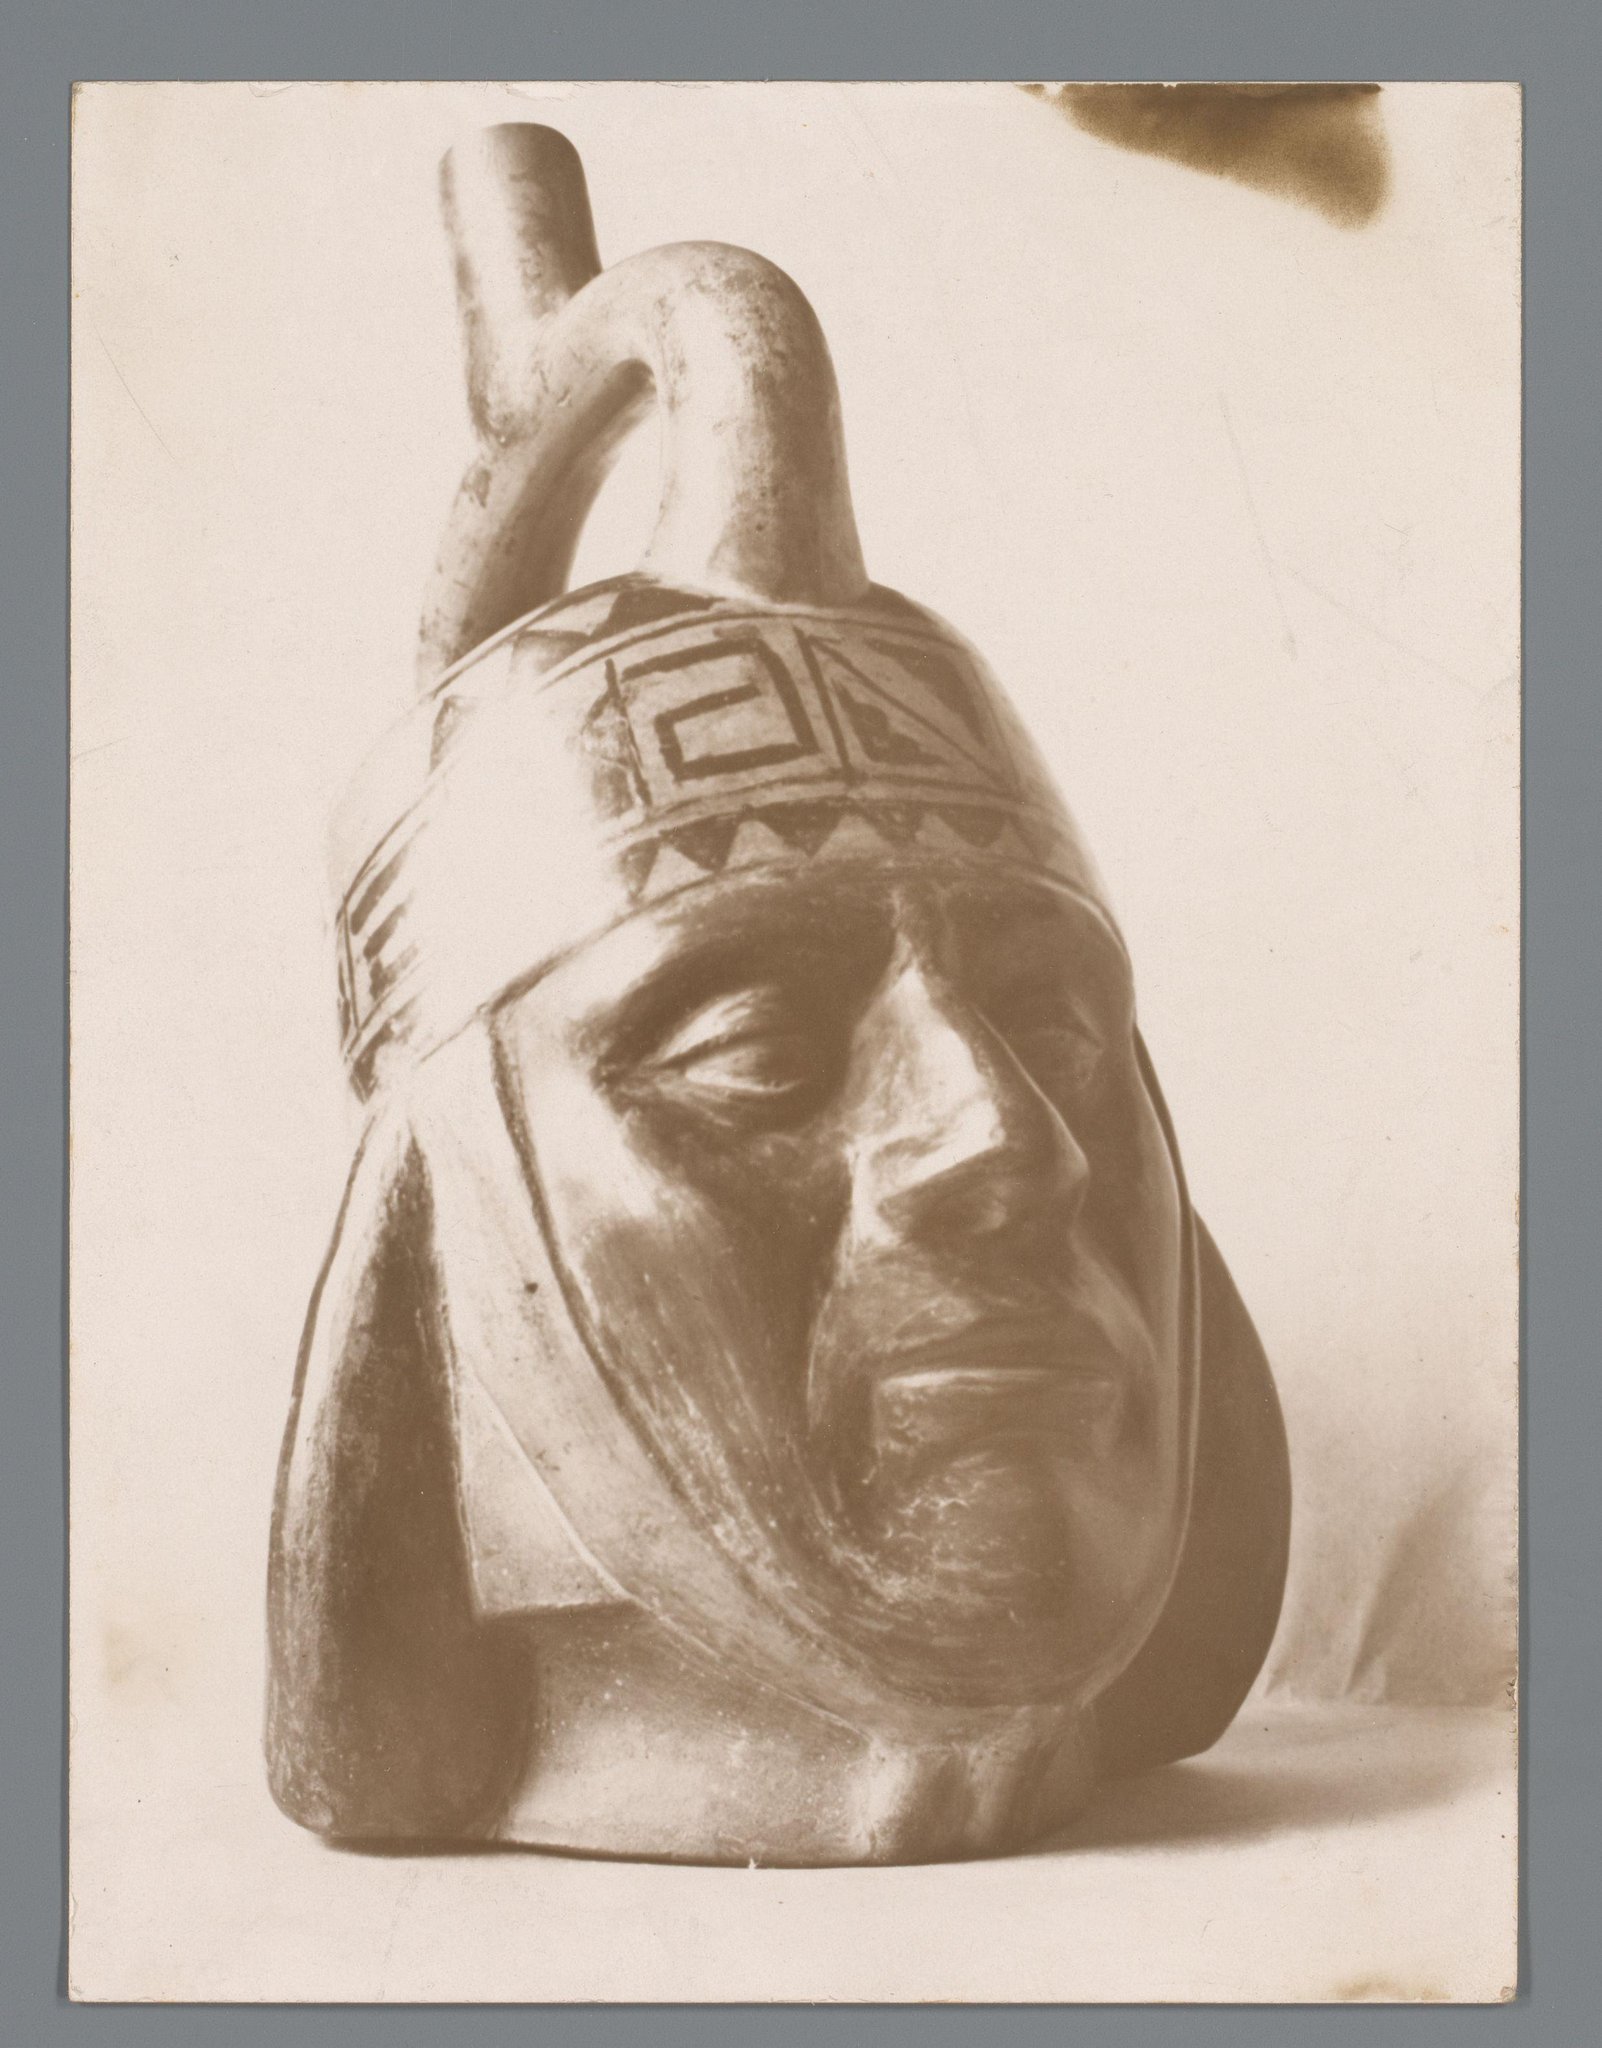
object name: photograph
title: Beeld van een kop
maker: Anonymous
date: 1880-1920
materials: paper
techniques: gelatin silver print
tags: head (human), piece of sculpture, reproduction of a piece of sculpture